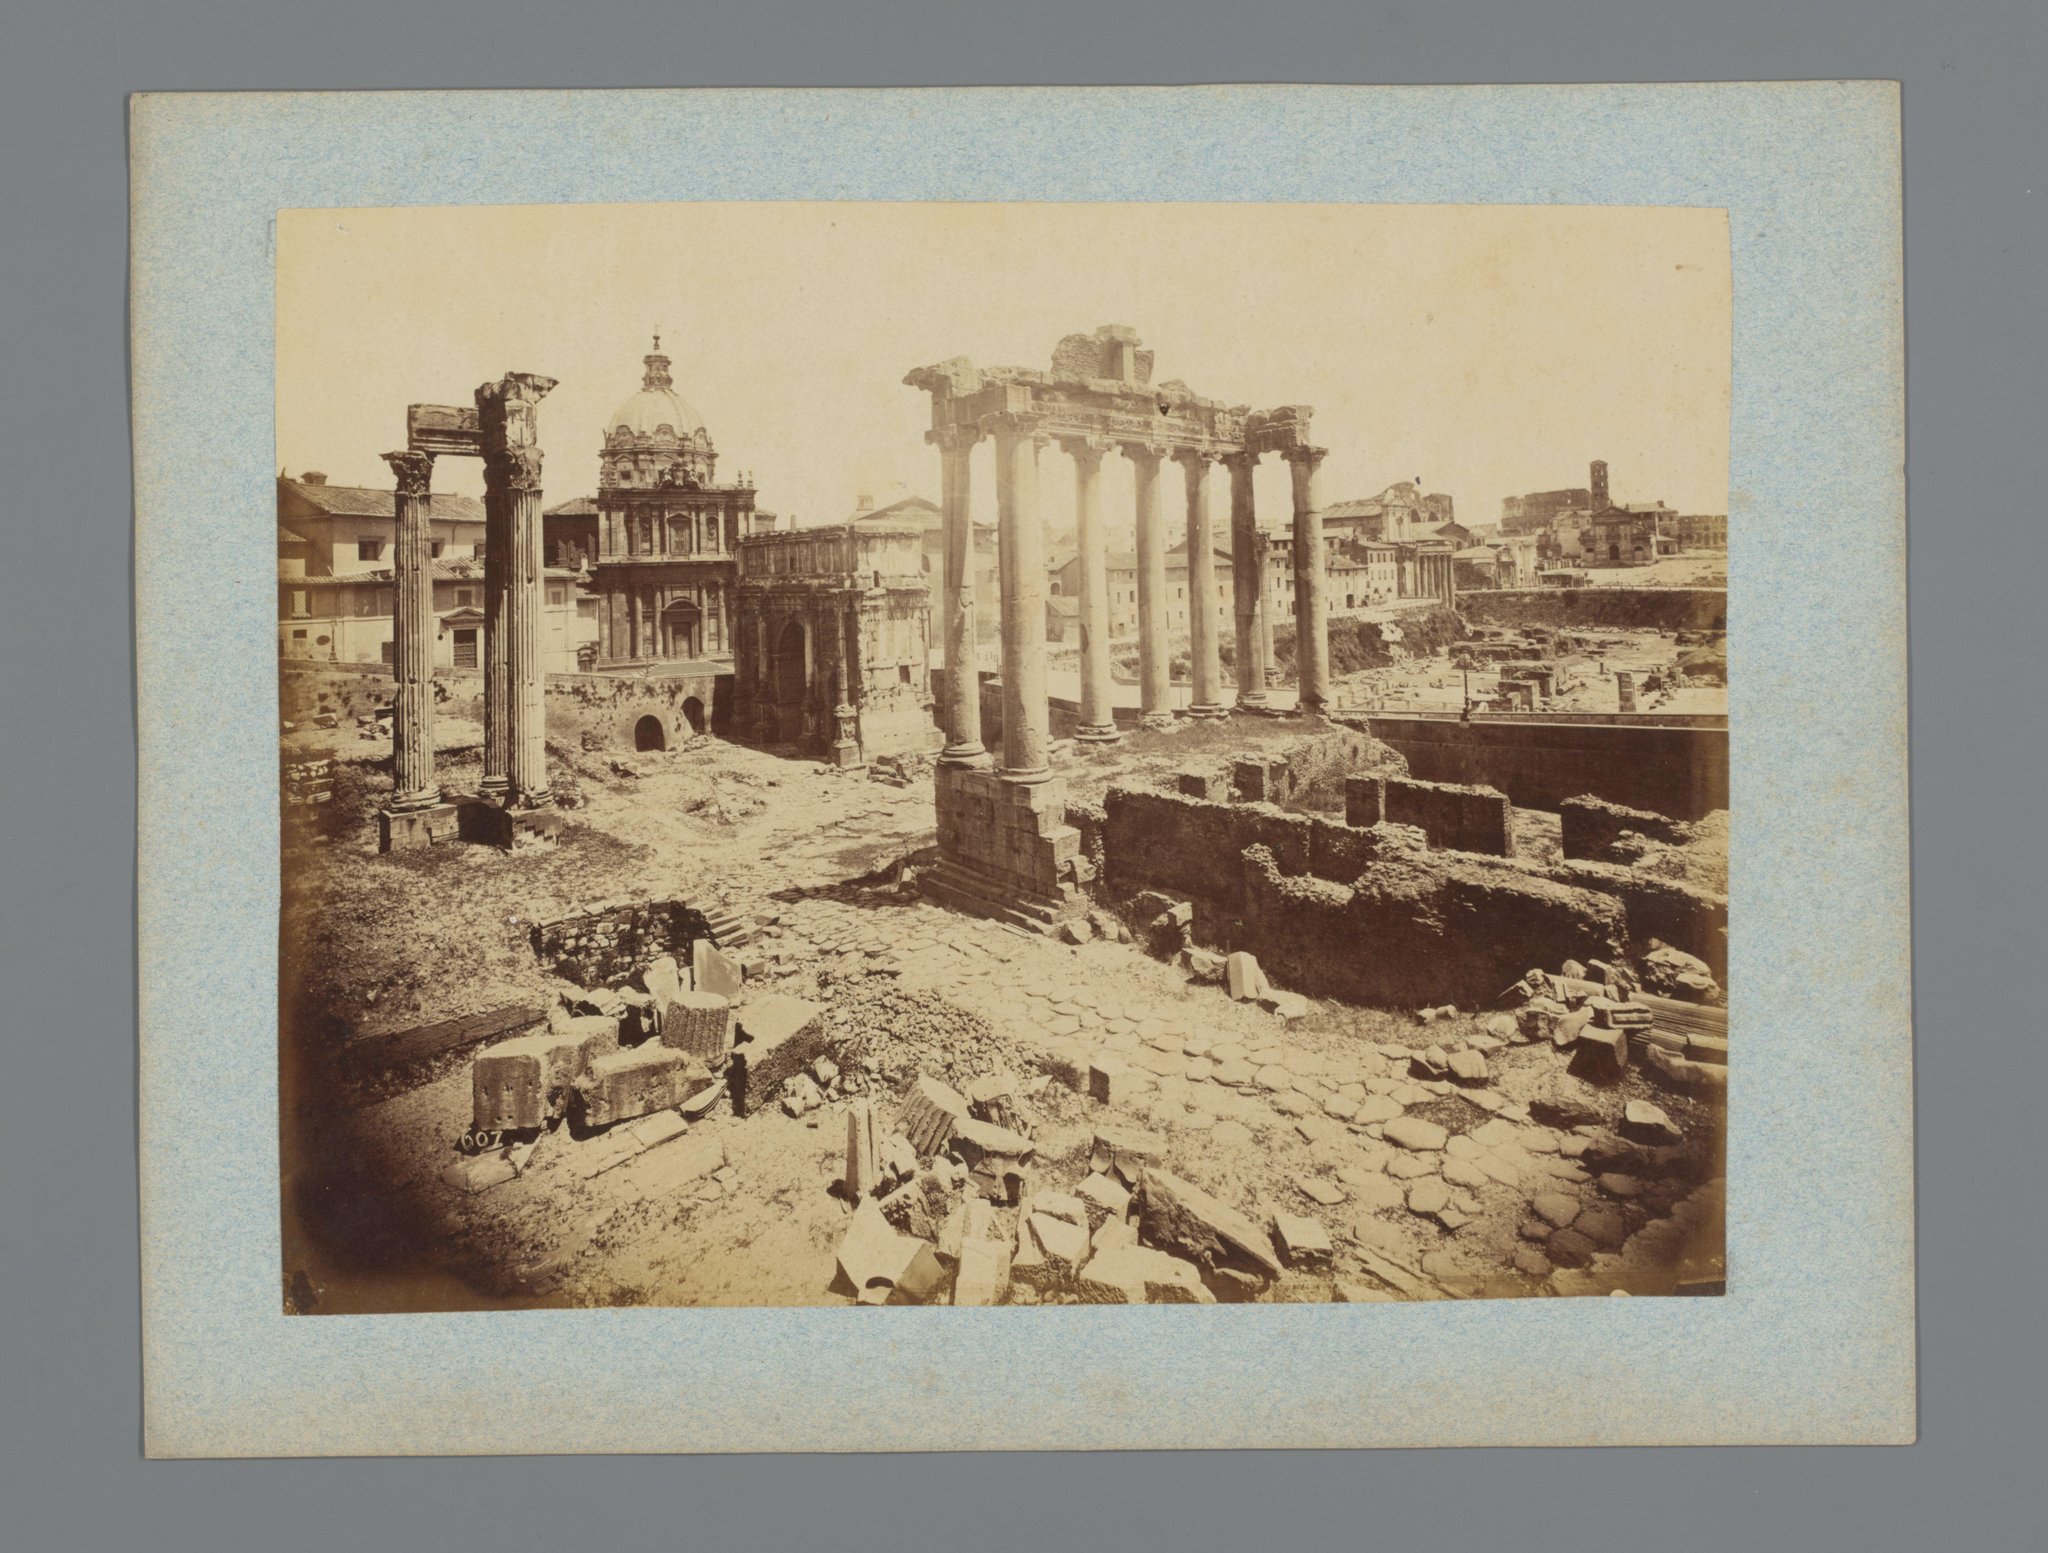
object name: photograph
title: Gezicht op het Forum Romanum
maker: Anonymous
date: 1851-1900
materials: cardboard, paper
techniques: albumen print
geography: forum romanum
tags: ruin of a building ~ architecture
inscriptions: number: ‘607’, collector's mark: ‘VOSMAER’